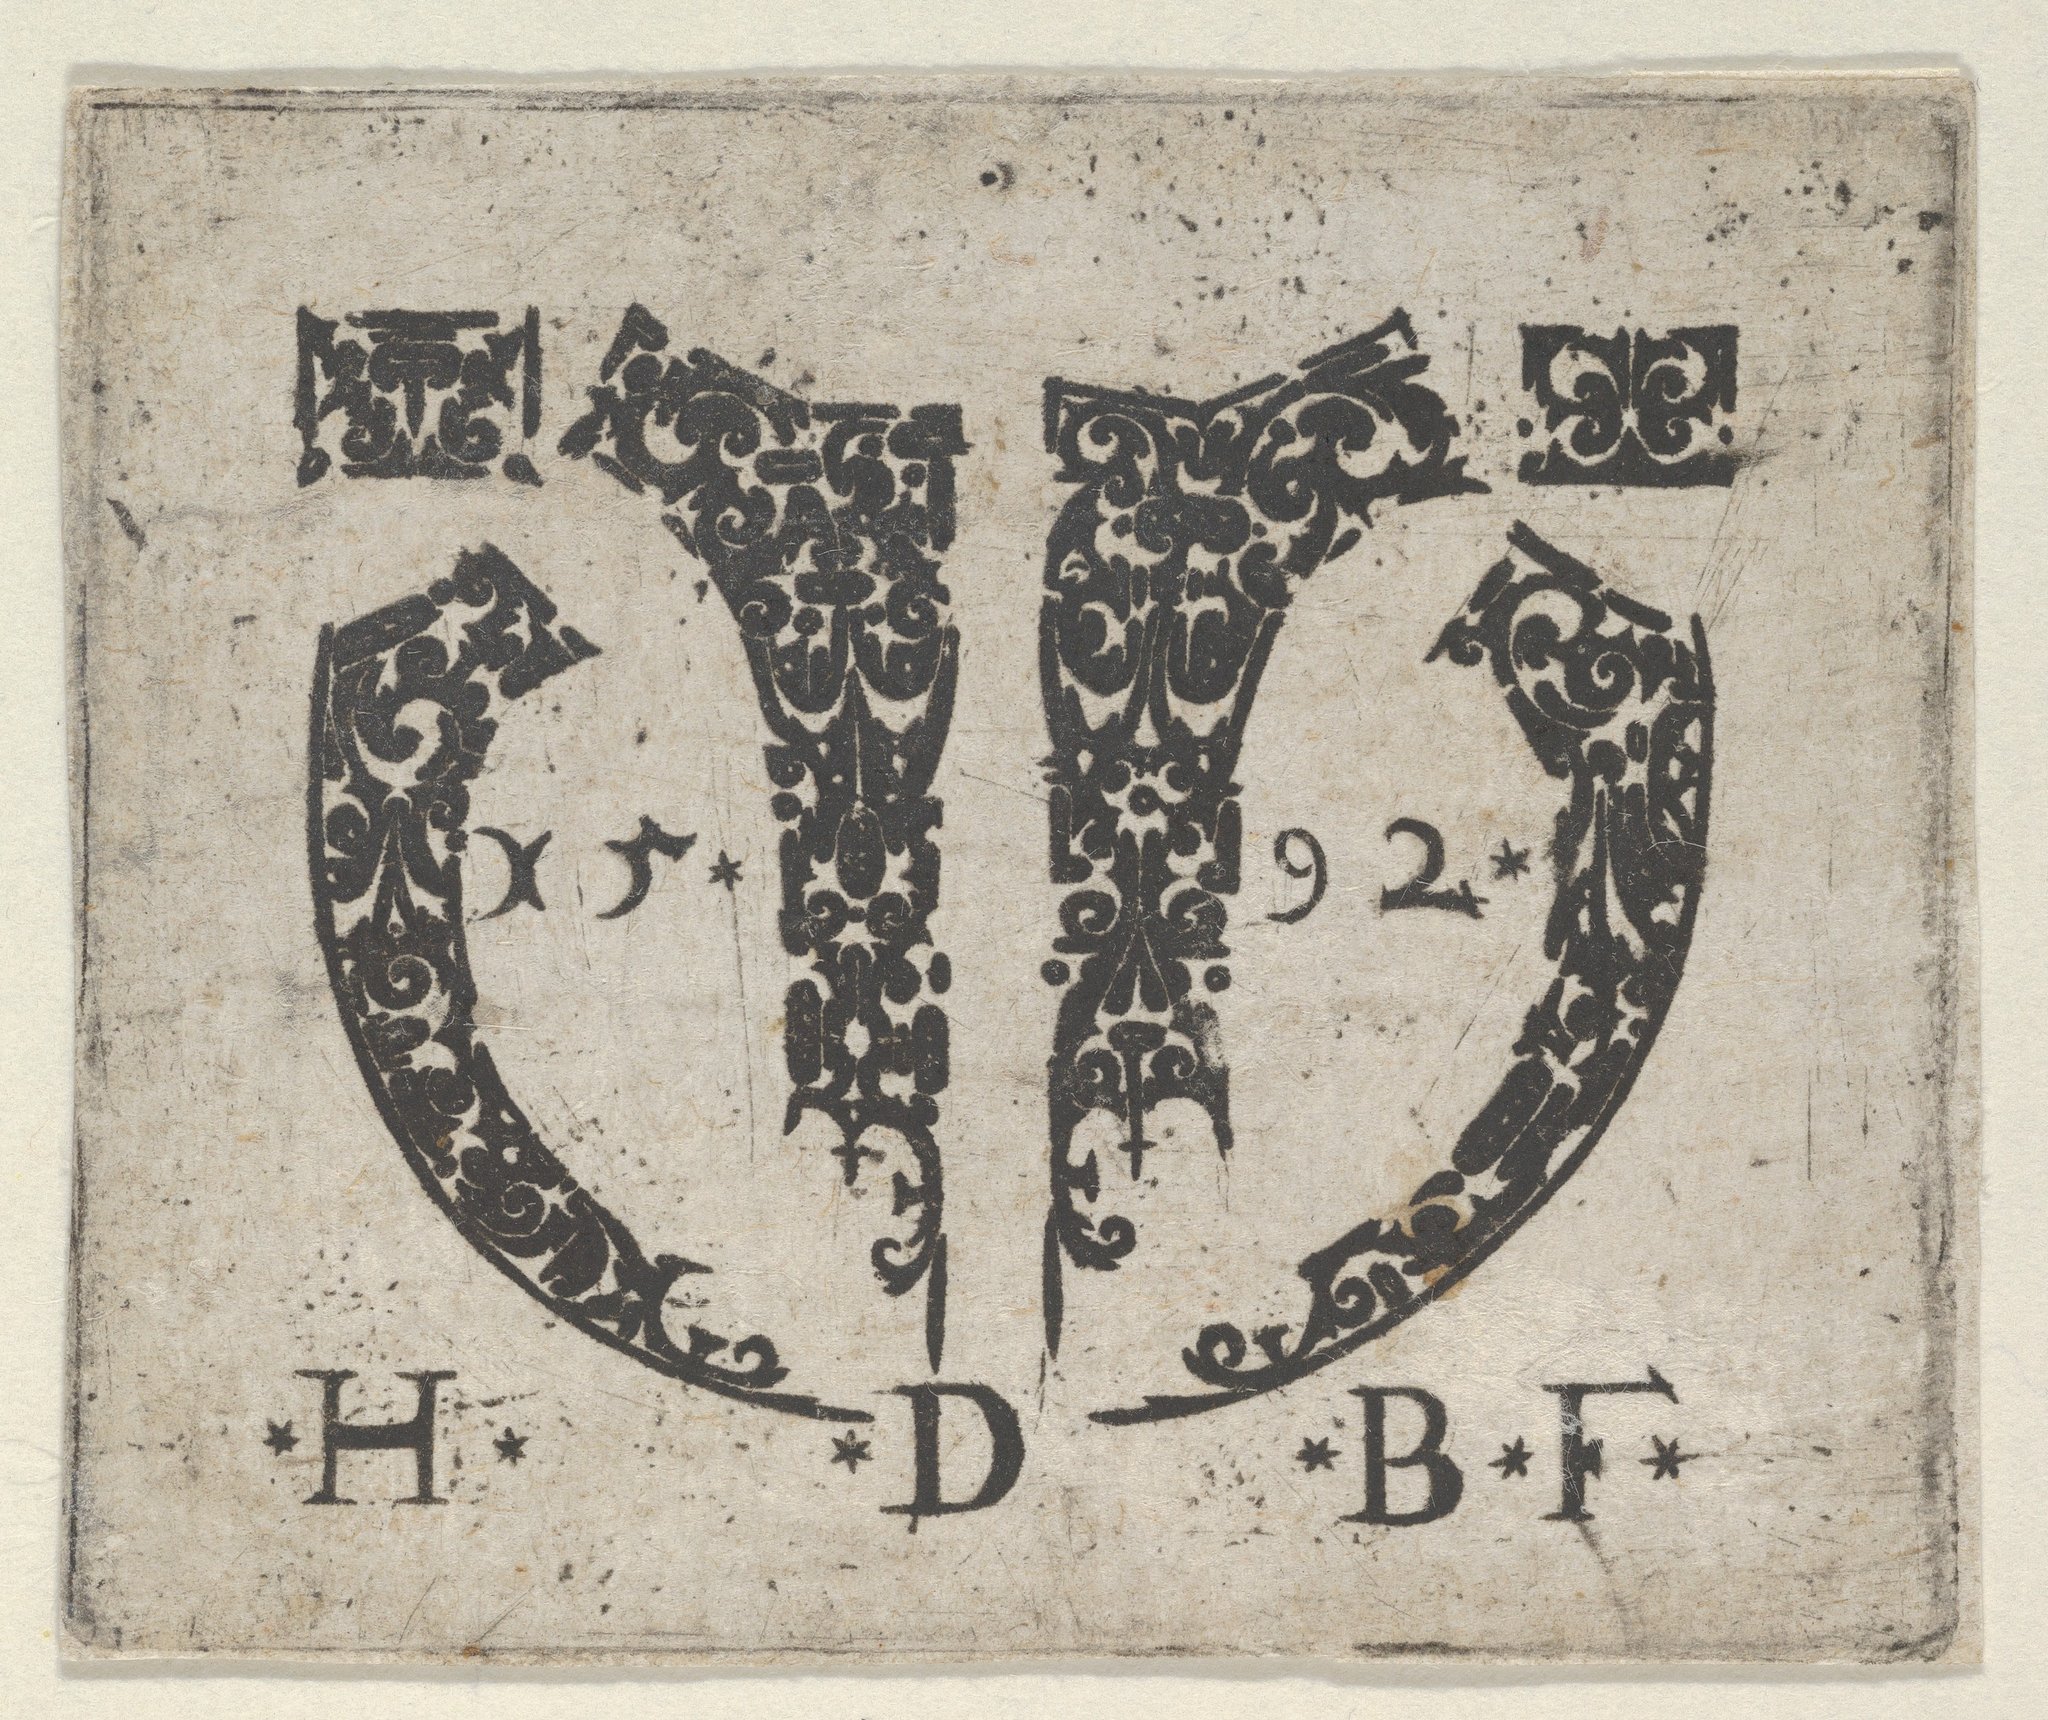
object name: print ornament architecture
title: Blackwork Print with Two Small Horizontal Panels Above a Pair of Lunar-Shaped Fillets with Two Motifs at Center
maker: hans de bull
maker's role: artist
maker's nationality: german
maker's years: 1592-1604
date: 1592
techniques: embroidery, engraving